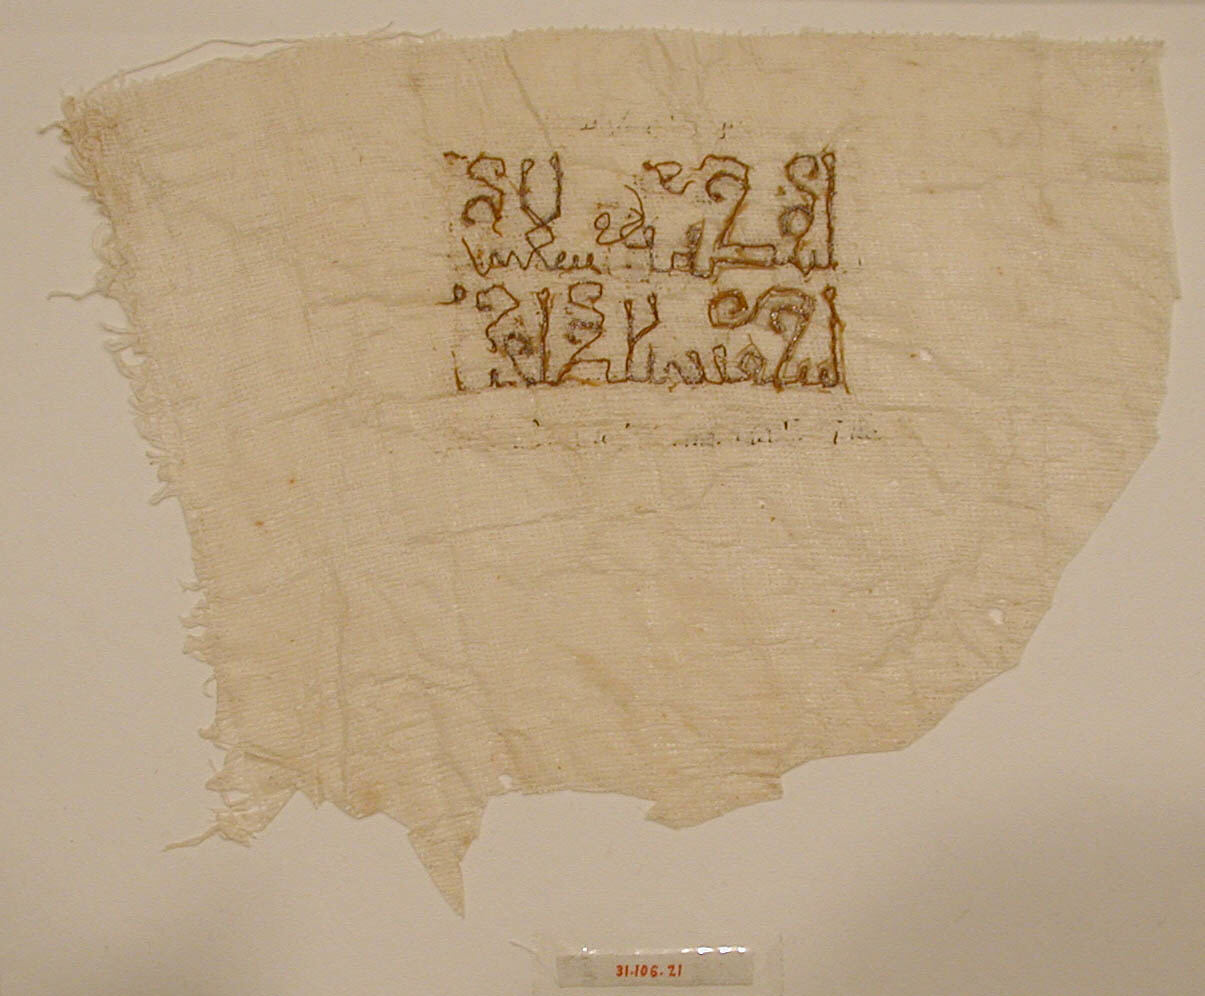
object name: textile fragment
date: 901-1000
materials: linen, metal thread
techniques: embroidery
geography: egypt